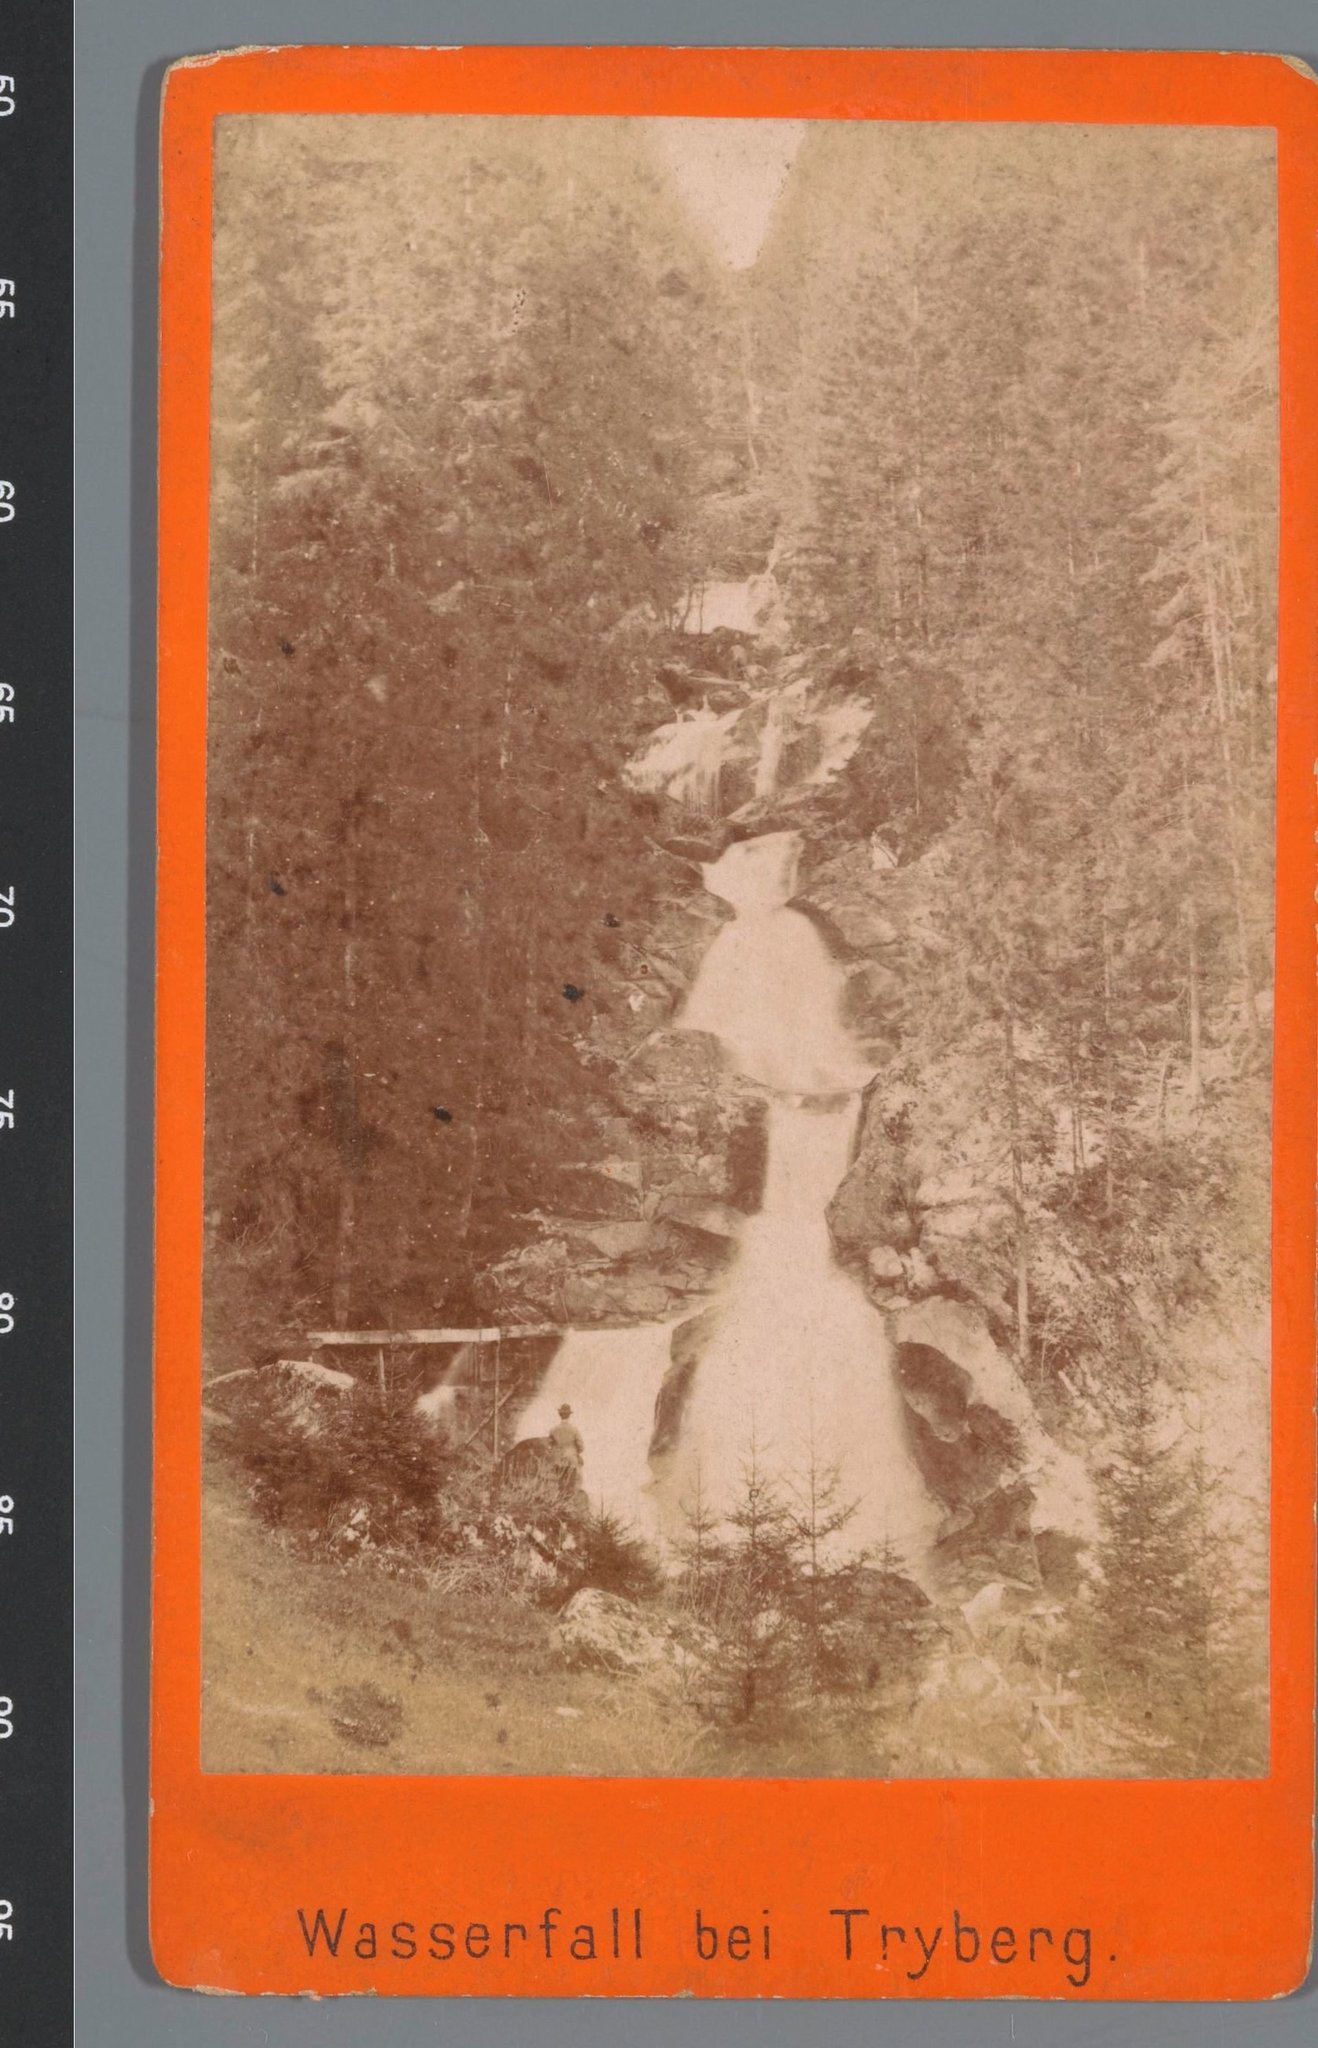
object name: carte de visite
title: Wasserfall bei Tryberg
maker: Anonymous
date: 1855-1885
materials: cardboard, paper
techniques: albumen print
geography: triberg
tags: waterfall